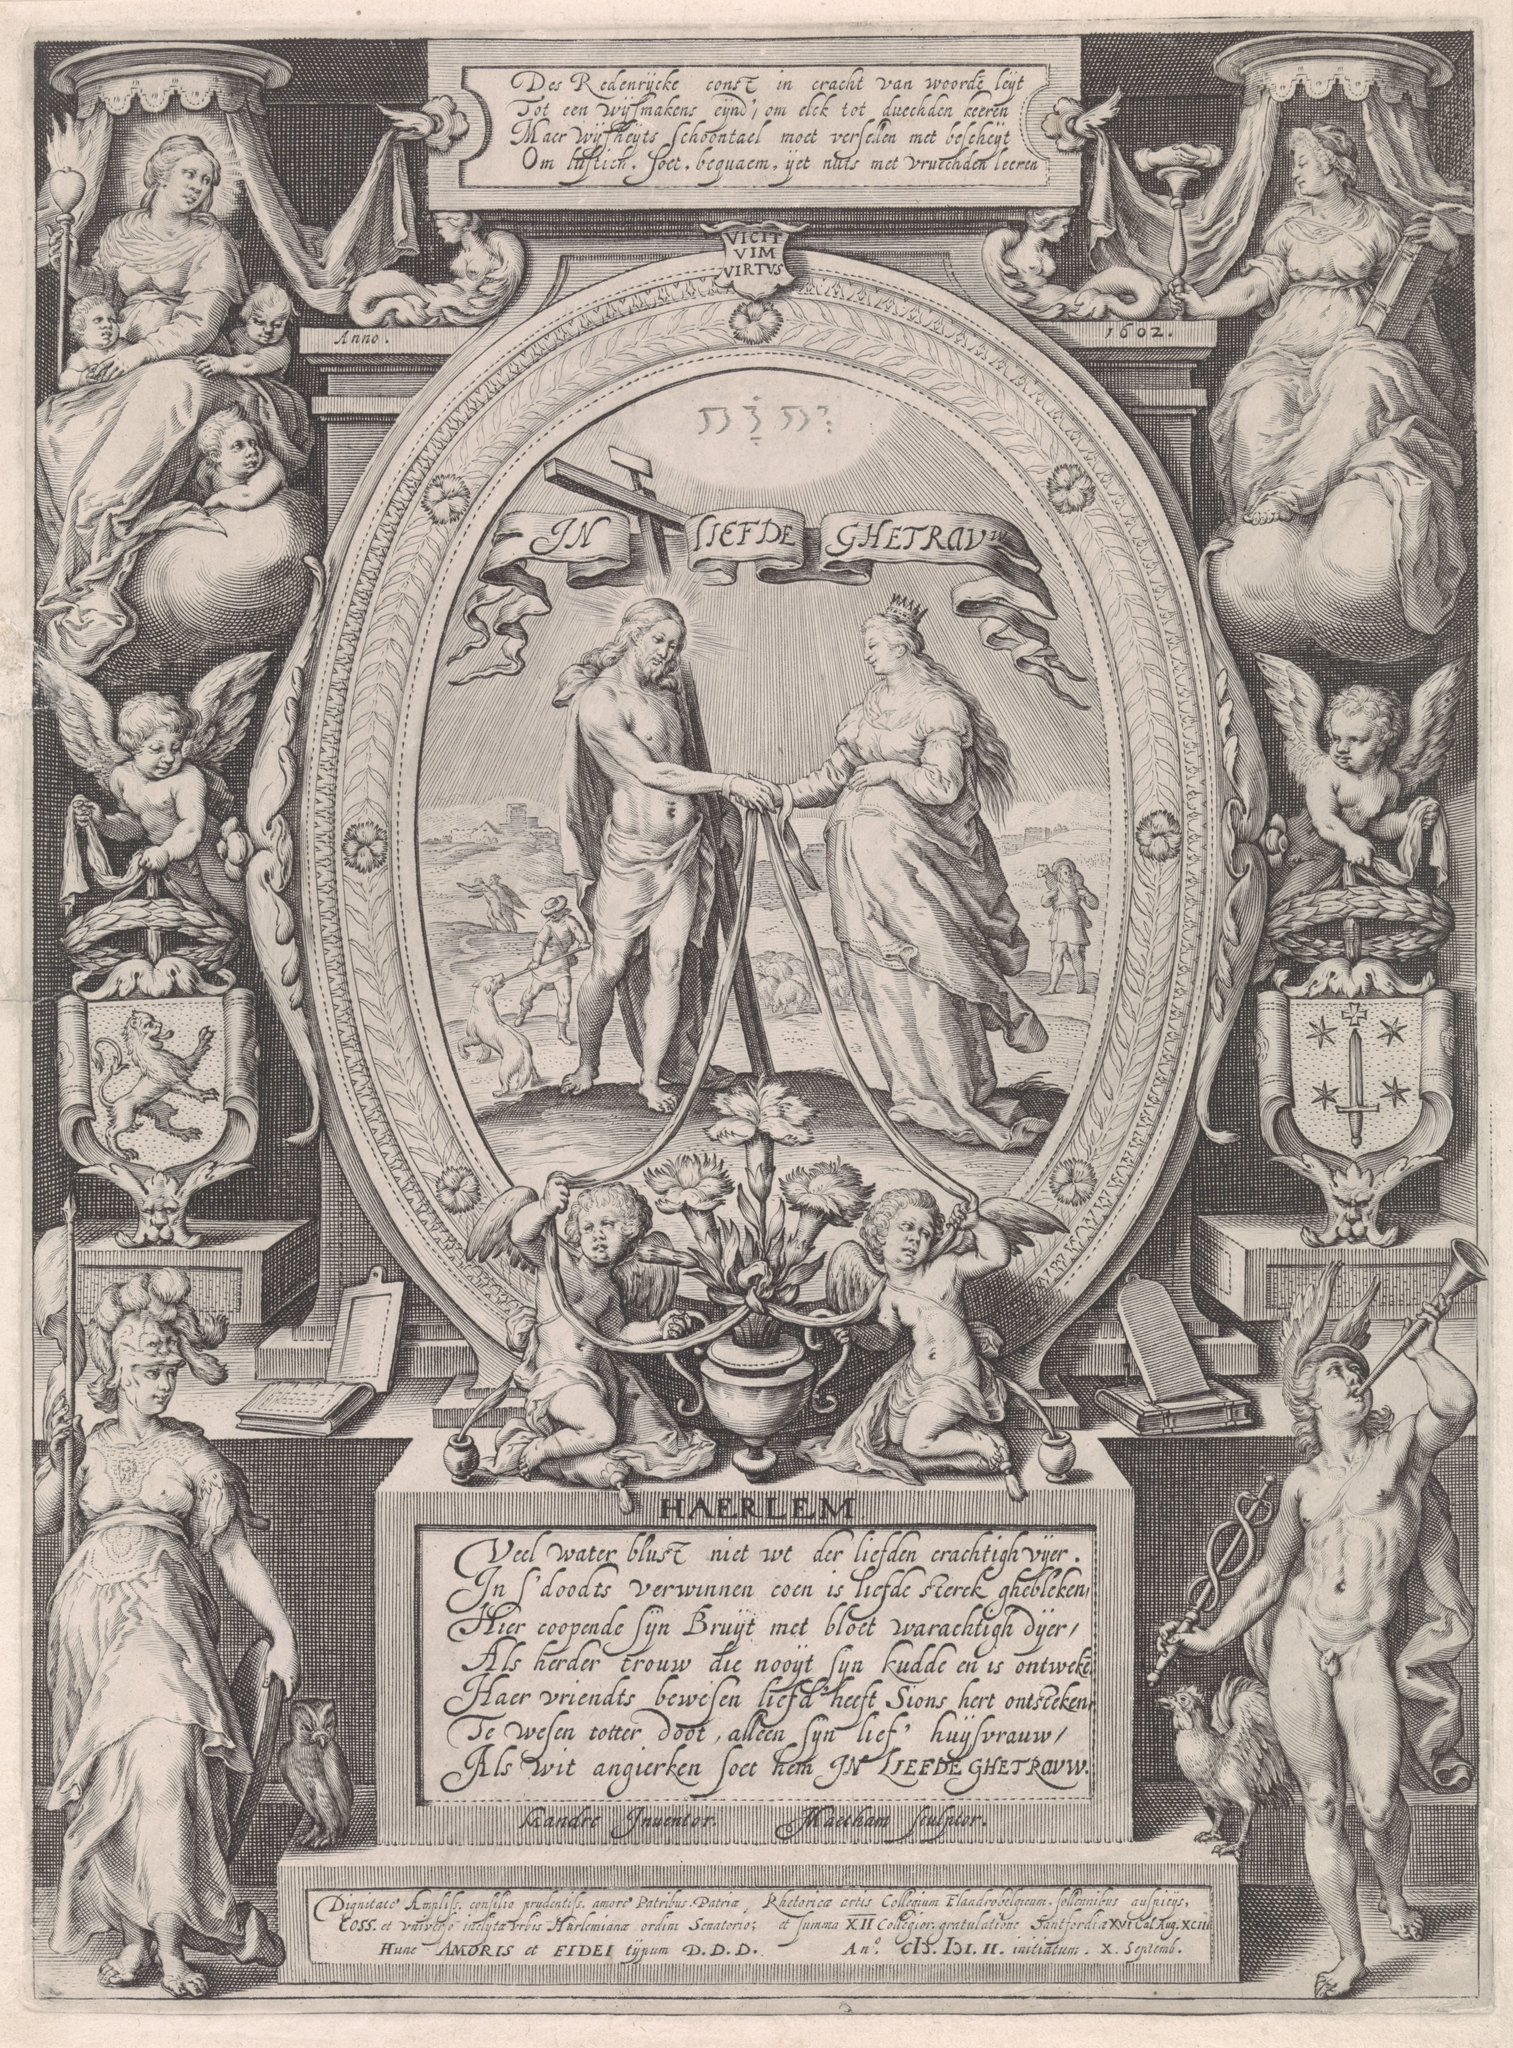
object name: print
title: Blazoen van de rederijkerskamer De witte angieren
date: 1602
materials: paper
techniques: engraving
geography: haarlem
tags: 'ecclesia' as bride of christ (the lamb), 'ecclesia sponsa dei', 'sponsus-sponsa' (+ christ (bearded)), specific aspects, allegorical aspects of minerva; minerva as patroness, specific aspects, allegorical aspects of mercury; mercury as patron, armorial bearing, heraldry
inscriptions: date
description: Blazoen van de rederijkerskamer De witte angieren. In het midden Christus als bruidegom van de Kerk (Ecclesia), omgeven door een ovaal cartouche met bovenaan twee allegorische figuren met een paar in elkaar geslagen handen en een brandend hart als attributen (Trouw en Liefde). Onderaan Minerva (links) en Mercurius (rechts).